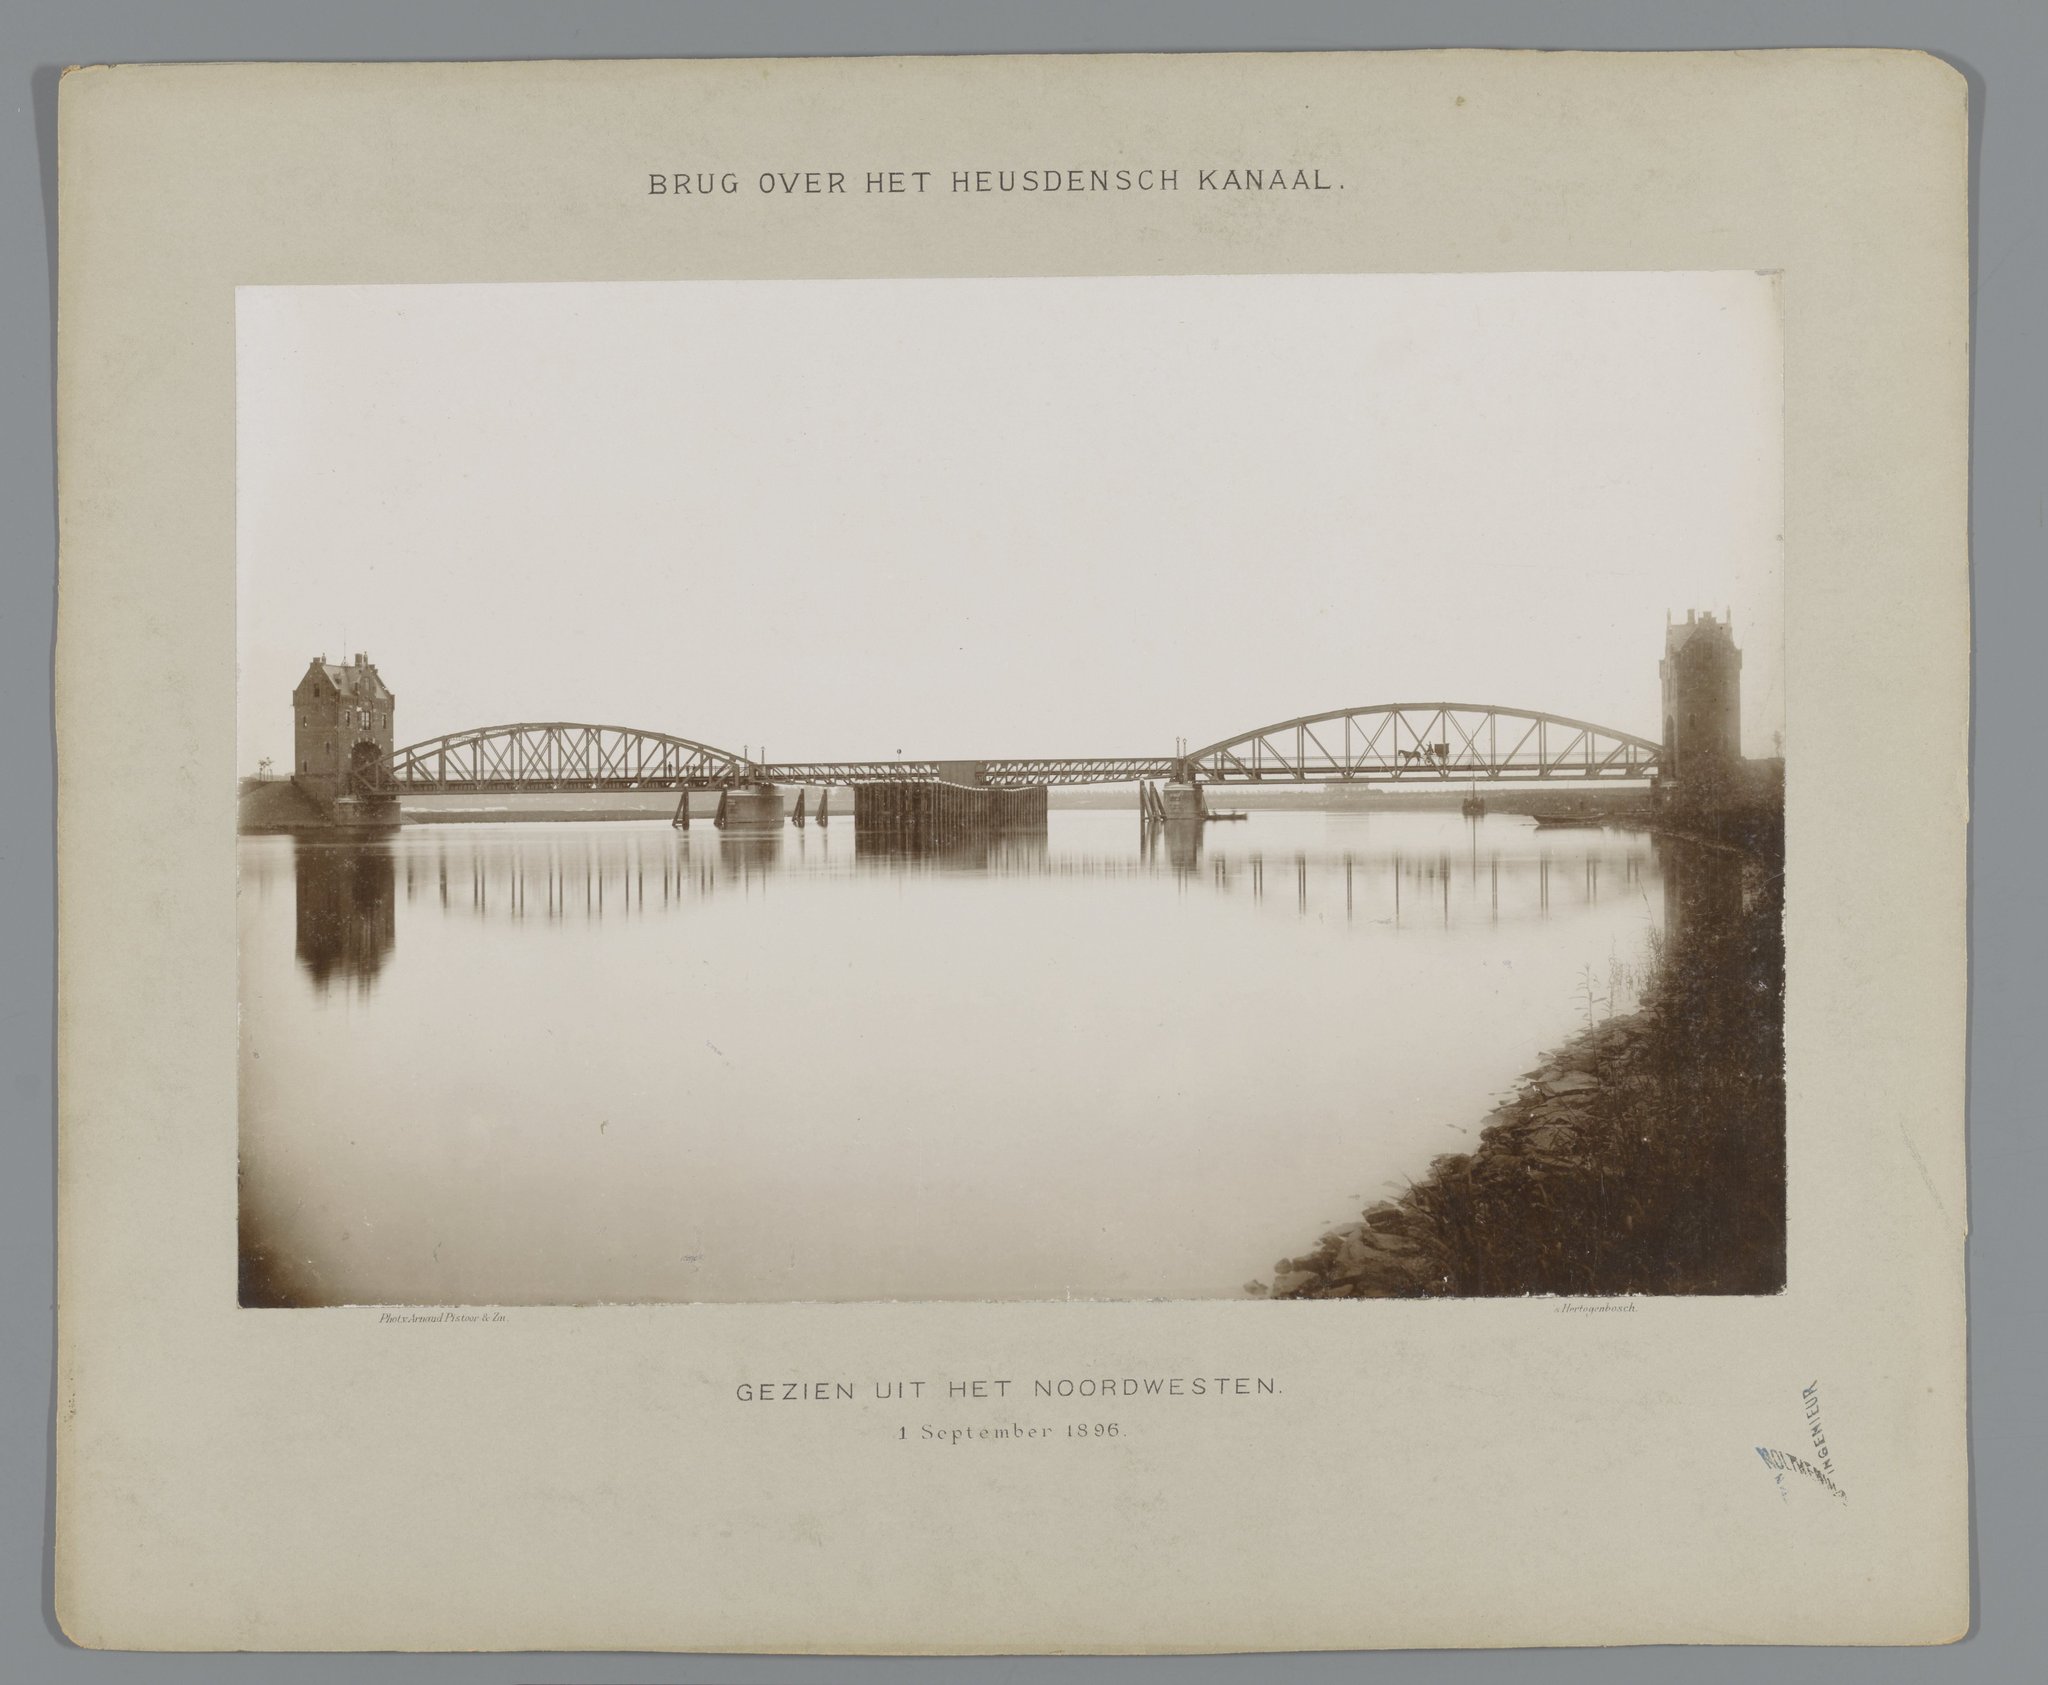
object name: photograph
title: Brug over het Heusdensch Kanaal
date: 1896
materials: cardboard, photographic support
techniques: collodion silver print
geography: north brabant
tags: bridge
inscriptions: stamp: ‘R.P. TUTEIN // NOLTHENIUS // INGENIEUR’, inscription: ‘BRUG OVER HET HEUSDENSCH KANAAL // GEZIEN UIT HET NOORDWESTEN’